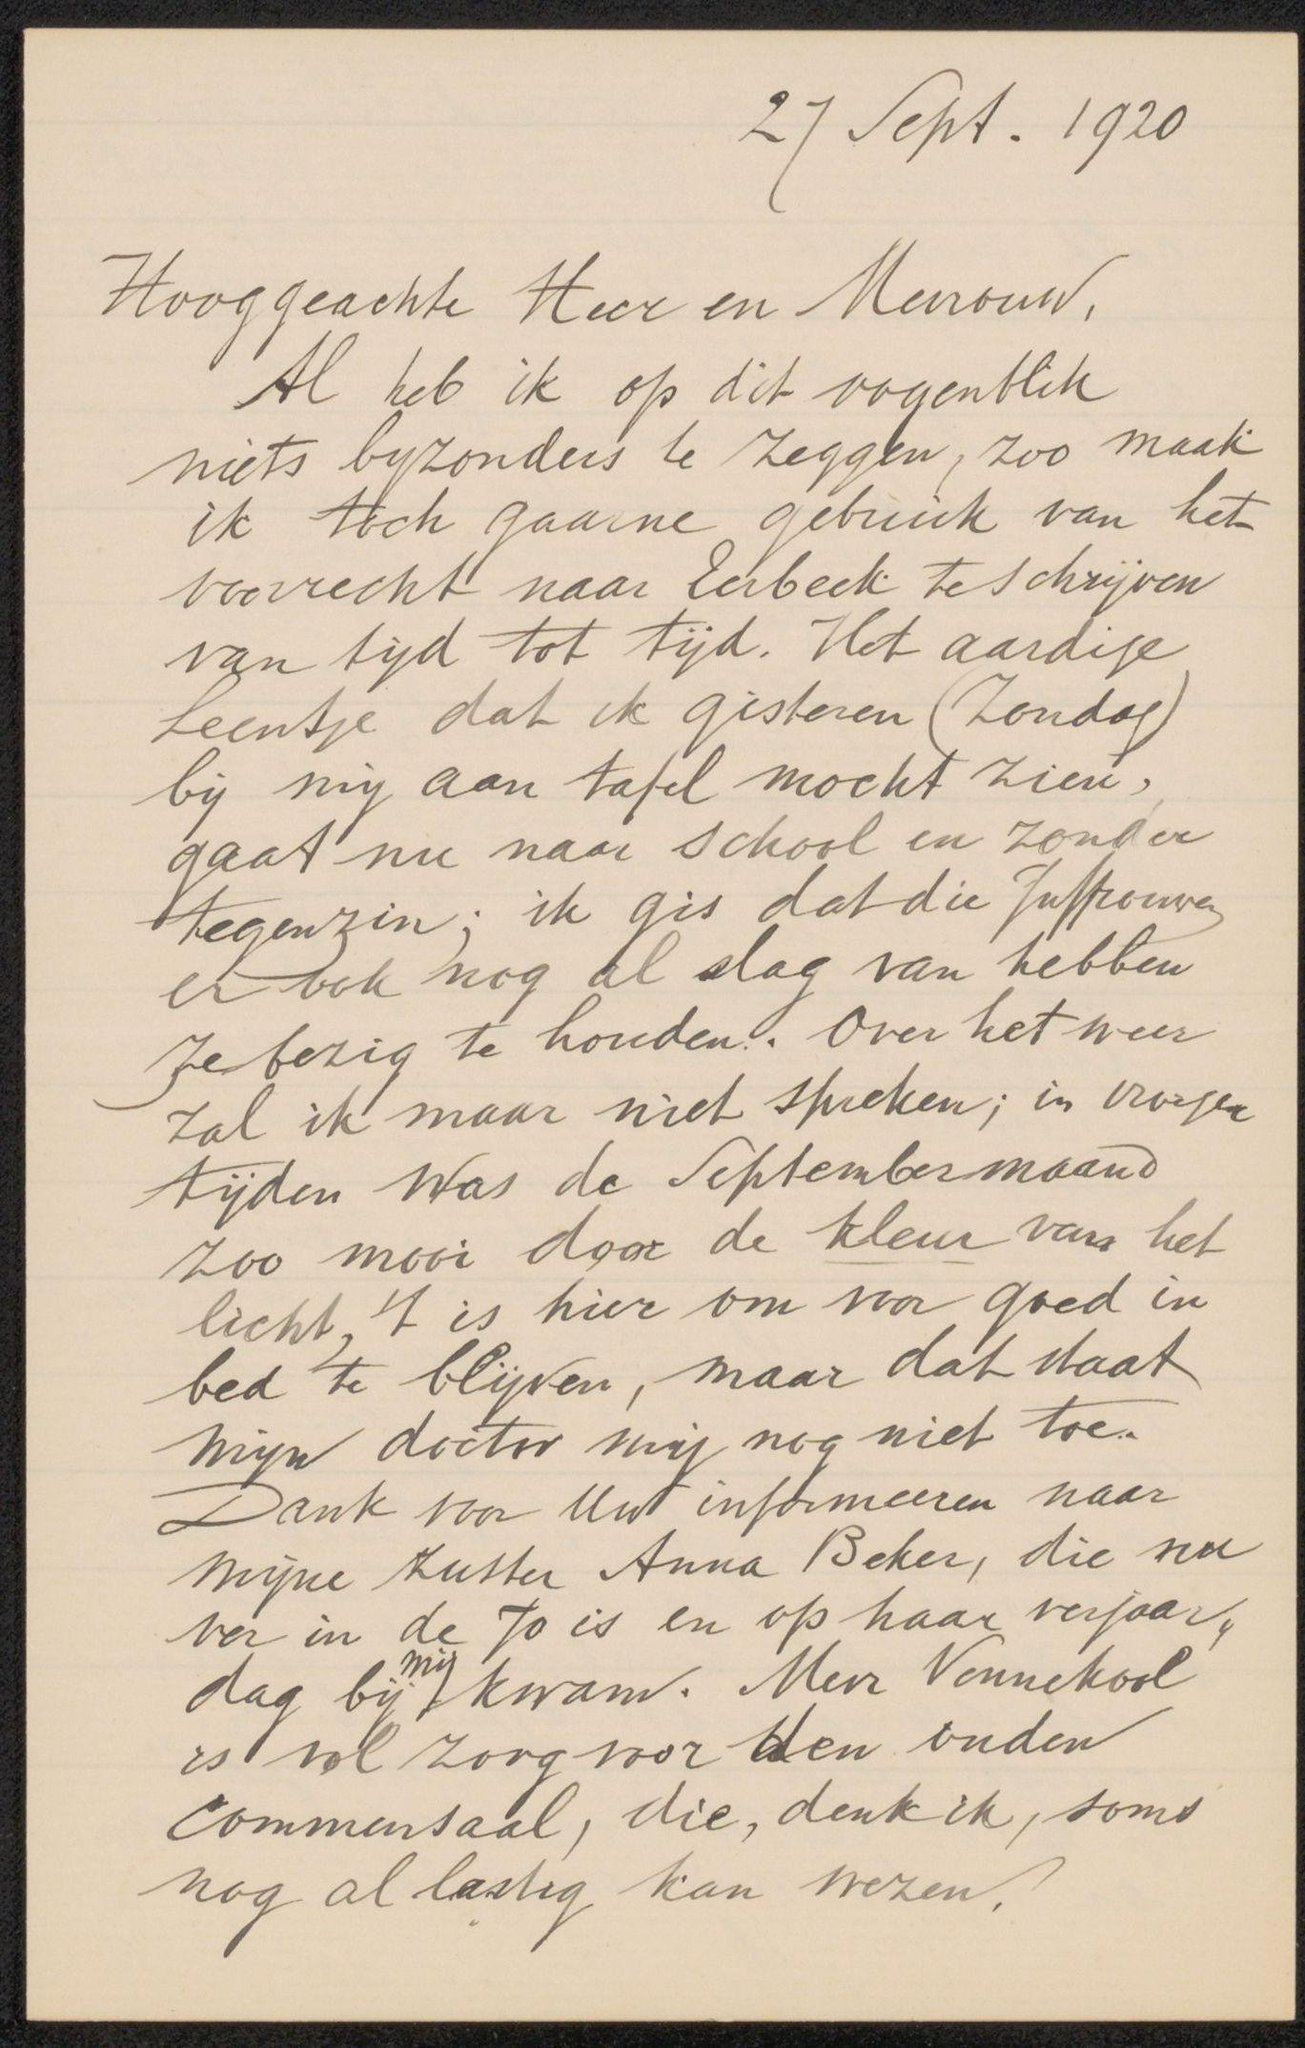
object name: letter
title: Brief aan Max Wilhelm Carl Weber en Anne Antoinette Weber-Van Bosse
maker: august allebé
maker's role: draughtsman, print maker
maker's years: 1838-1927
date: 1920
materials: ink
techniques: pen, writing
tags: adolphe mouilleron, paris, print maker, draughtsman, eugène delacroix, amsterdam, anne antoinette weber-van bosse, the graphic arts, travelling; tourism, switzerland